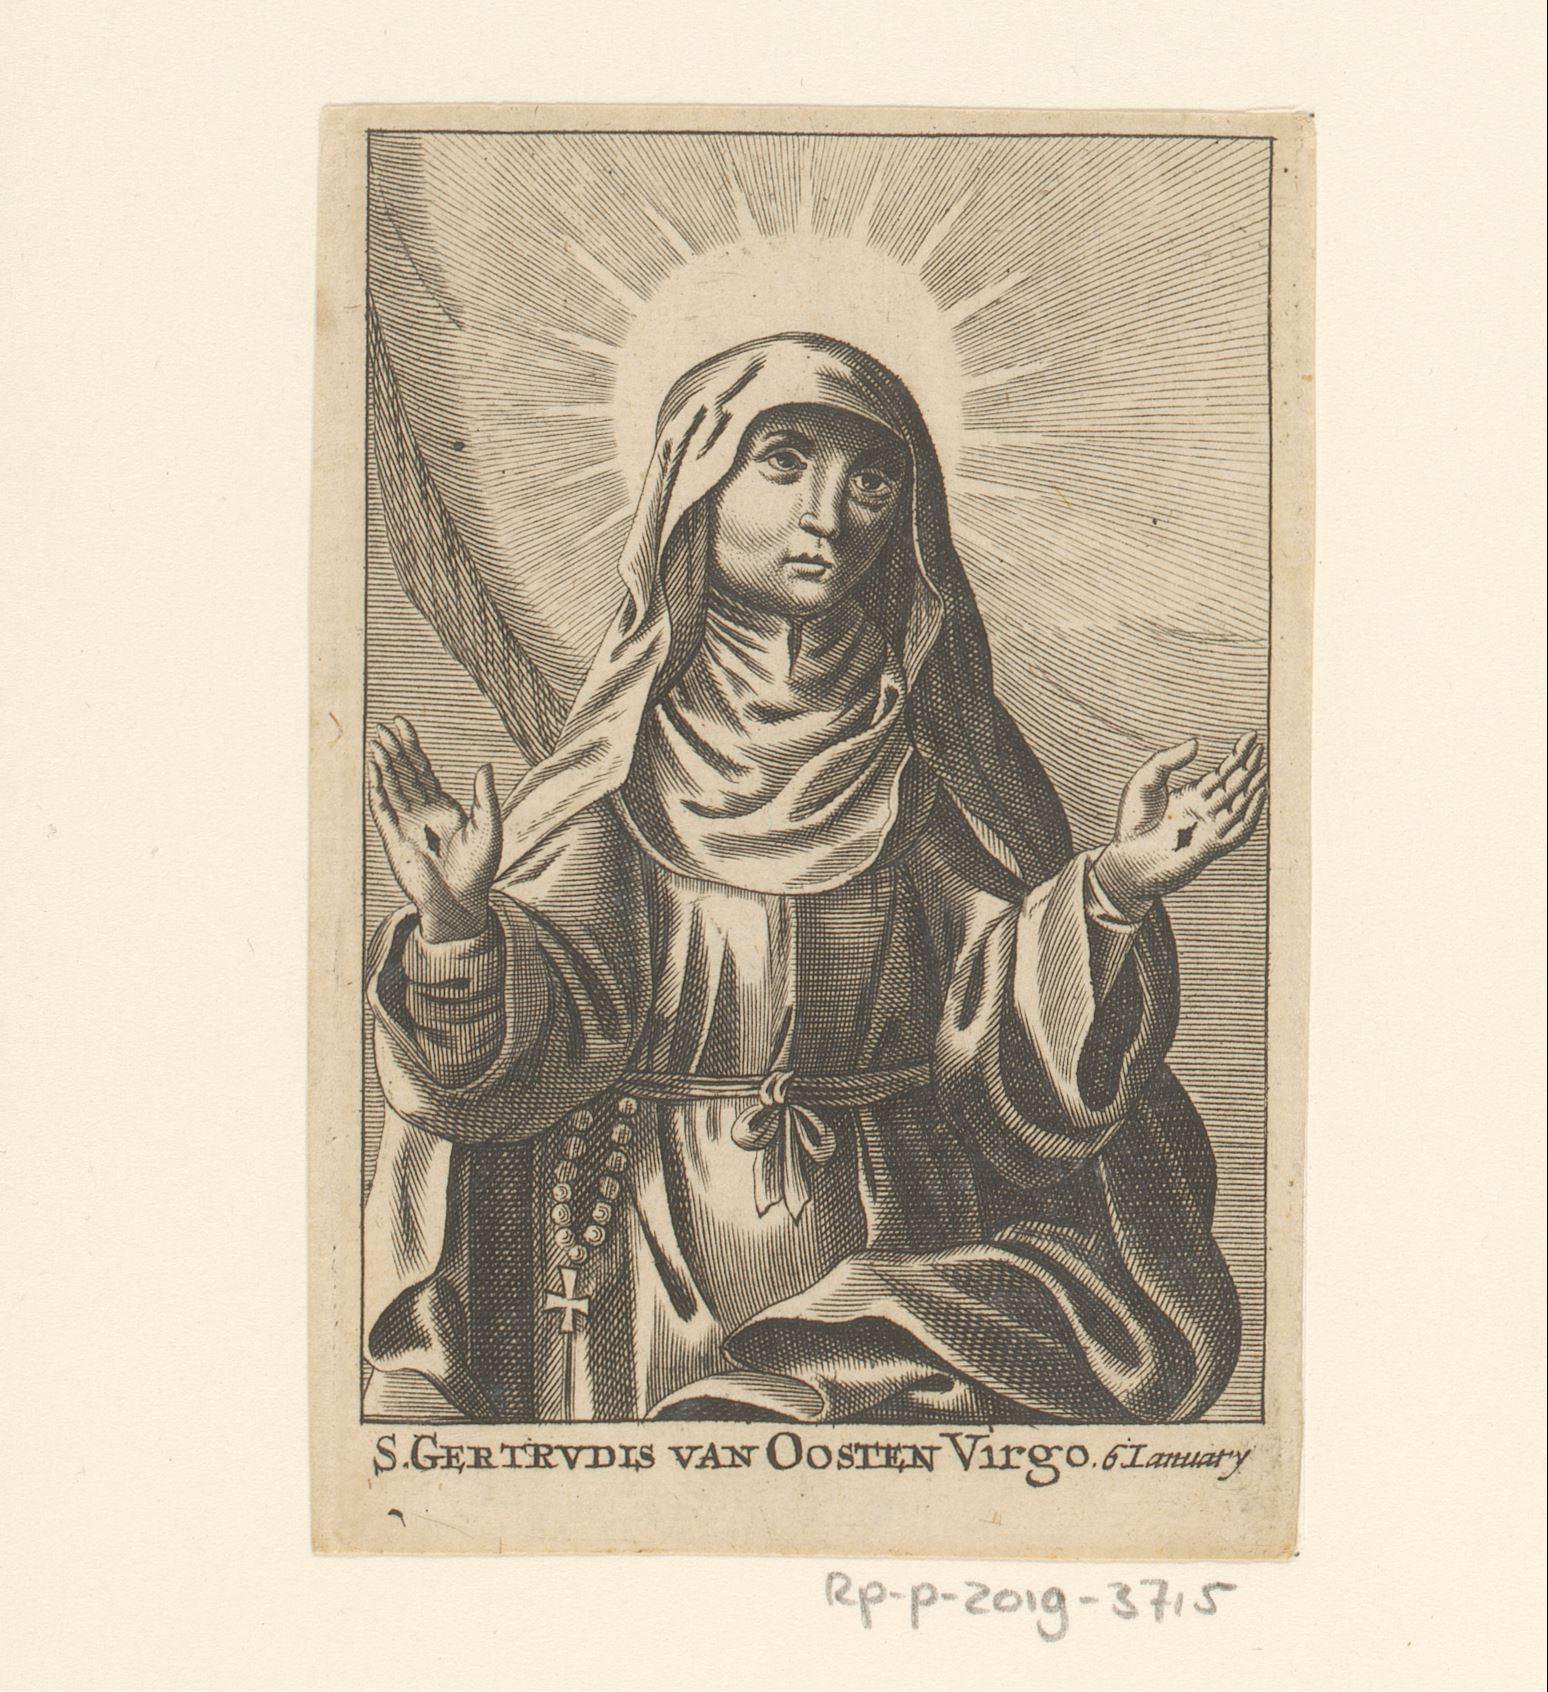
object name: print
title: Vrouwelijke heiligen en hun naamdagen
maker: Anonymous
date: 1600-1699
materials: paper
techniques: engraving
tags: female saints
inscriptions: collector's mark: Lugt 2228